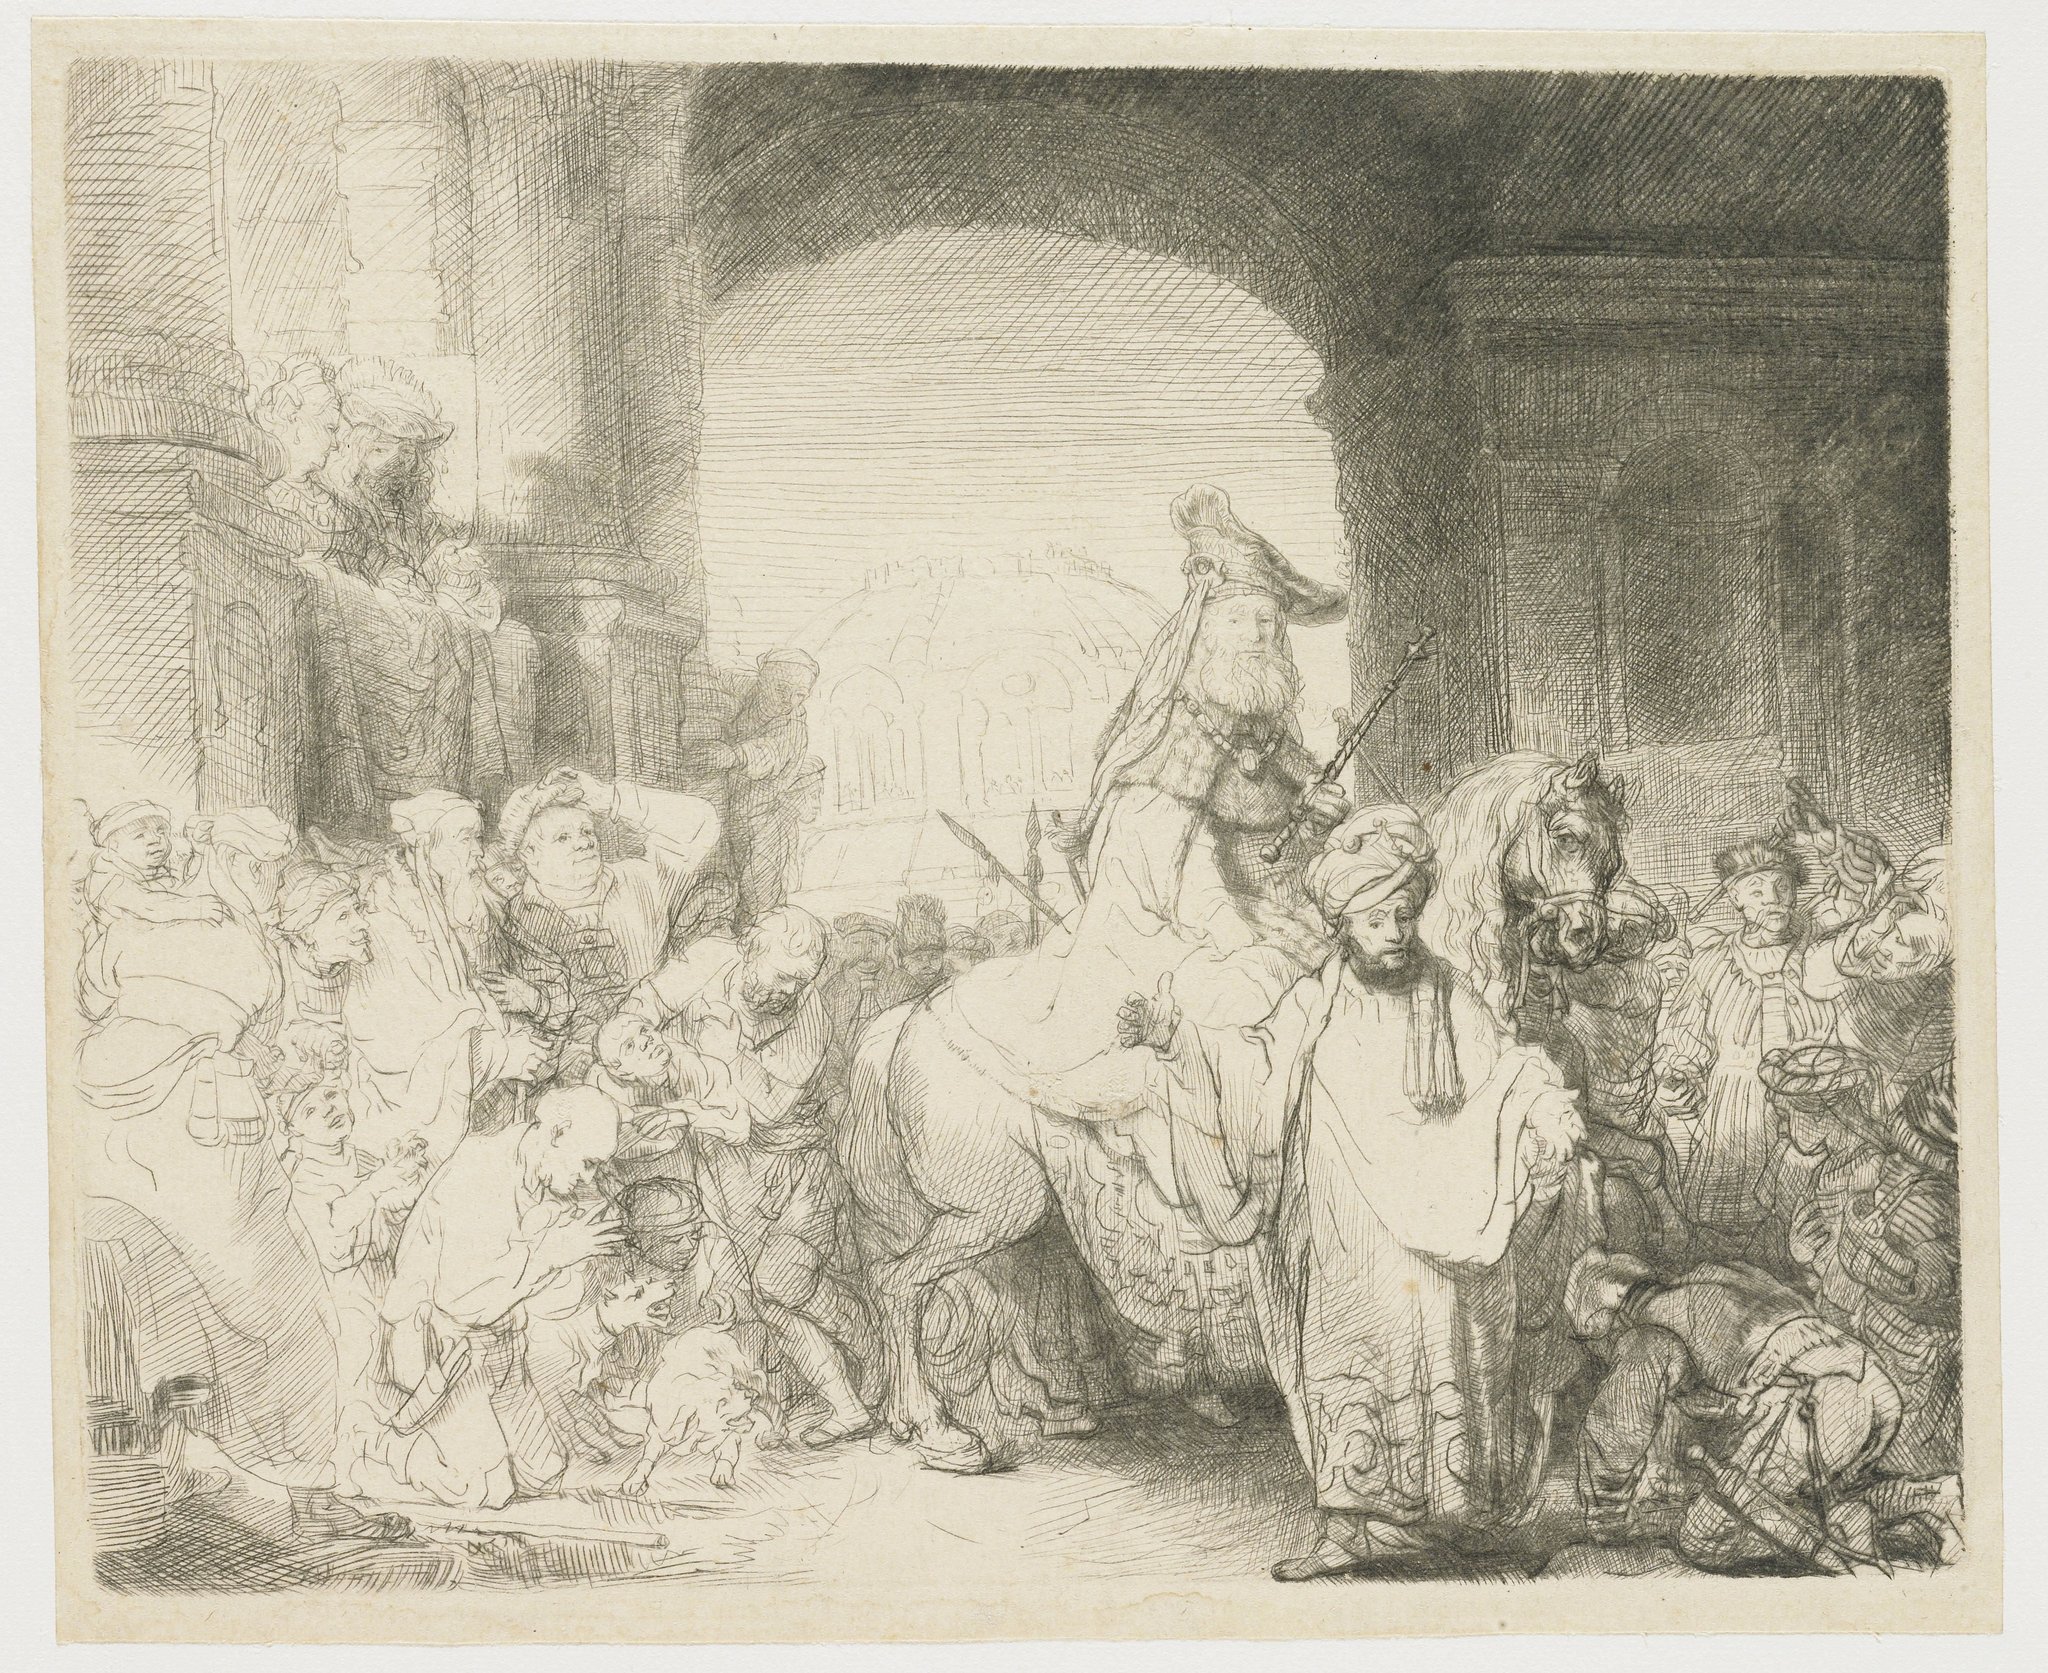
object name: print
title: The triumph of Mordecai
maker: rembrandt van rijn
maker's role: draughtsman, painter, print maker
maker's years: 1606-1669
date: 1641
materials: paper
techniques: printmaking, drypoint, etching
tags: mordecai's triumph: mordecai, mounted on the king's horse, is led through the city by haman (esther and ahasuerus may be looking on from the palace)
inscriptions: collector's mark: Lugt 240